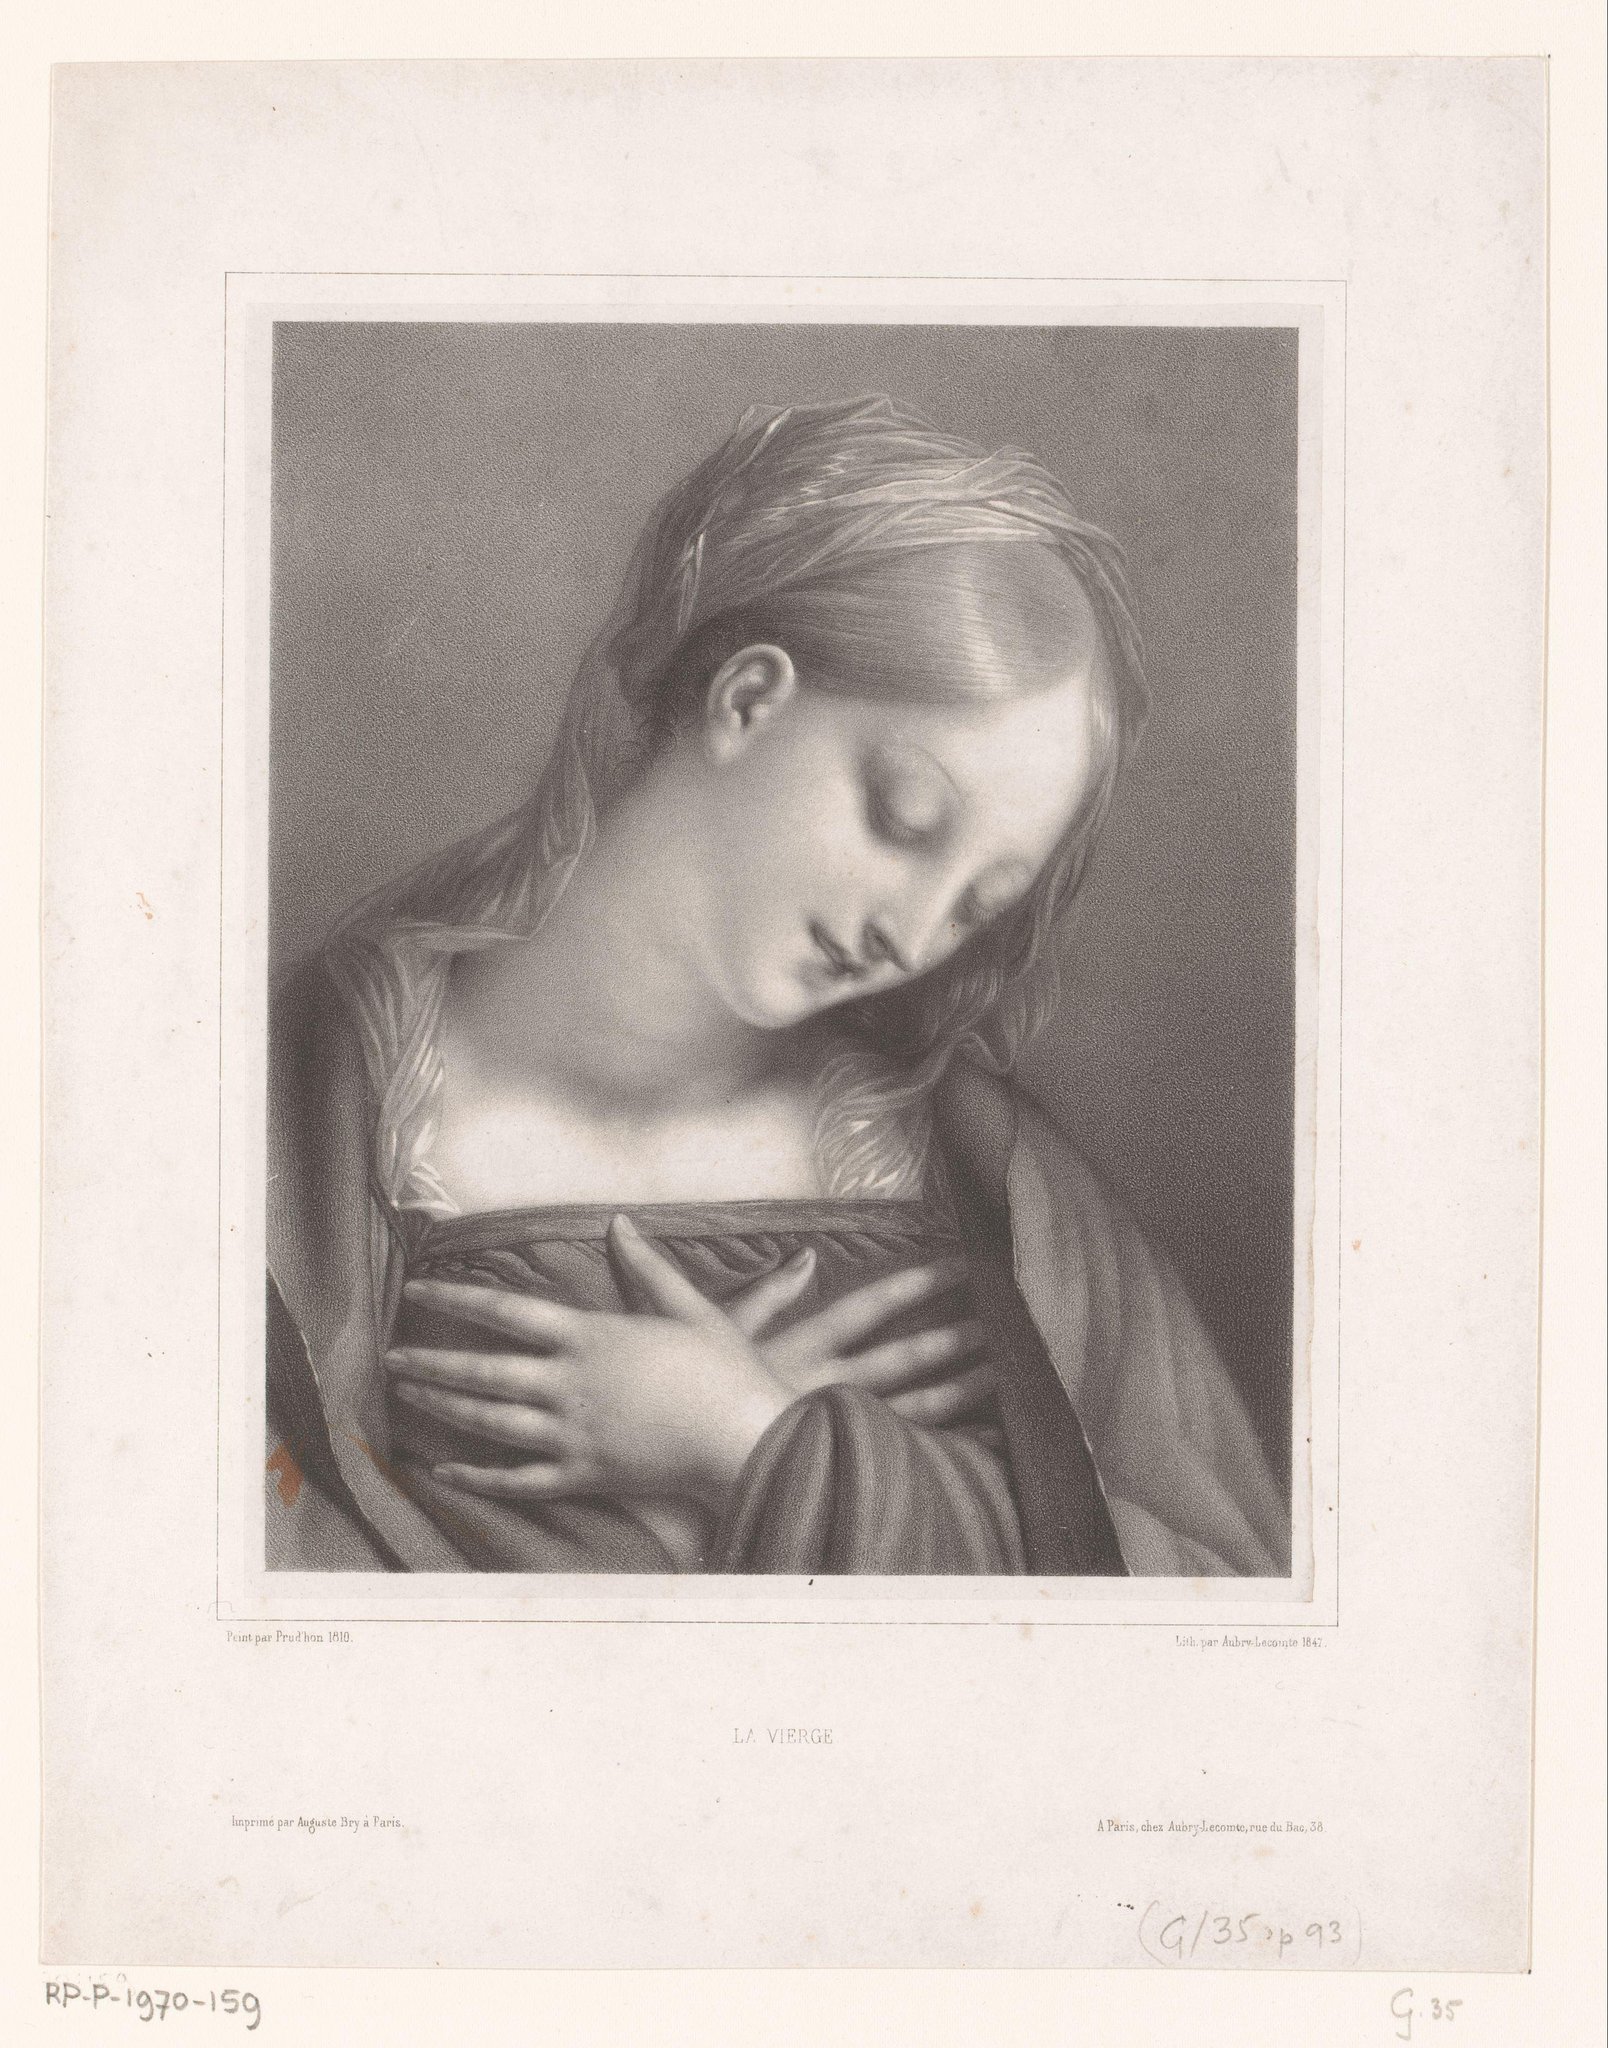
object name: print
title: Maria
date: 1847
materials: paper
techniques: lithograph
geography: paris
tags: mary (without the christ-child)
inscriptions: collector's mark: Lugt 2228a, collector's mark: Lugt 2760